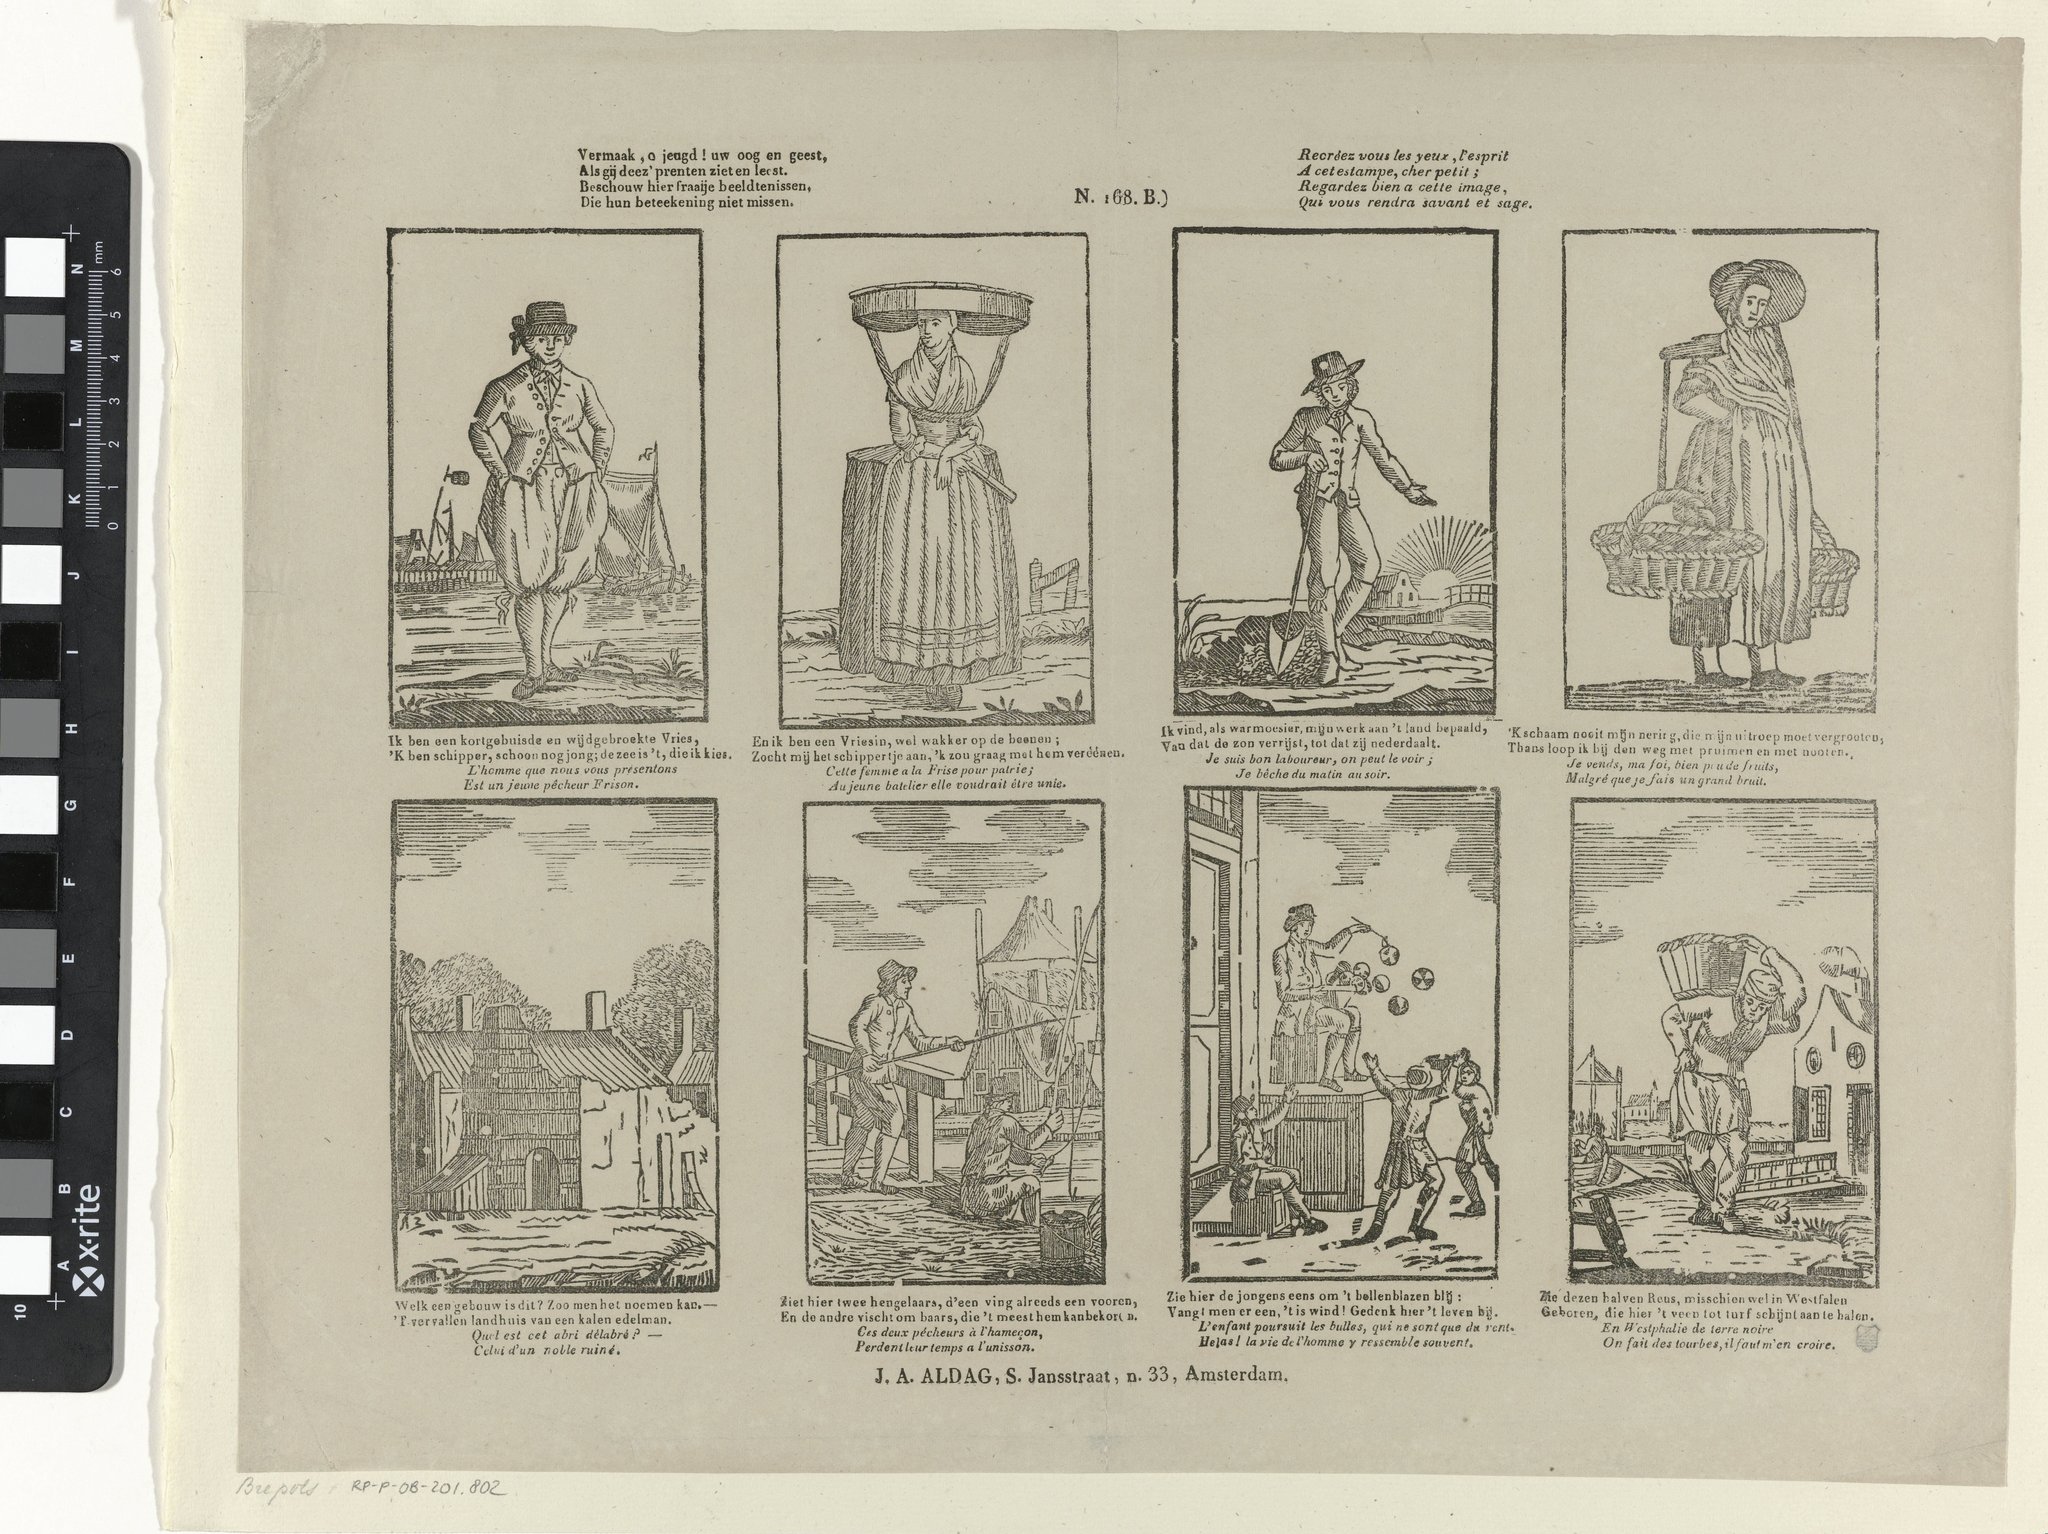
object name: popular print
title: Vermaak, o jeugd! uw oog en geest, / Als gij deez' prenten ziet en leest [(...)]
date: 1851-1880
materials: paper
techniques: letterpress printing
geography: amsterdam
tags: farmers, street-trader, crafts and industries, fisherman, merchant, salesman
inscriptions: collector's mark: Lugt 2760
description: Blad met 8 voorstellingen van beroepen, waaronder een schipper, een boer en vissers. Onder elke afbeelding een tweeregelig vers in het Nederlands en in het Frans. Genummerd midden boven: N. 168. B.).